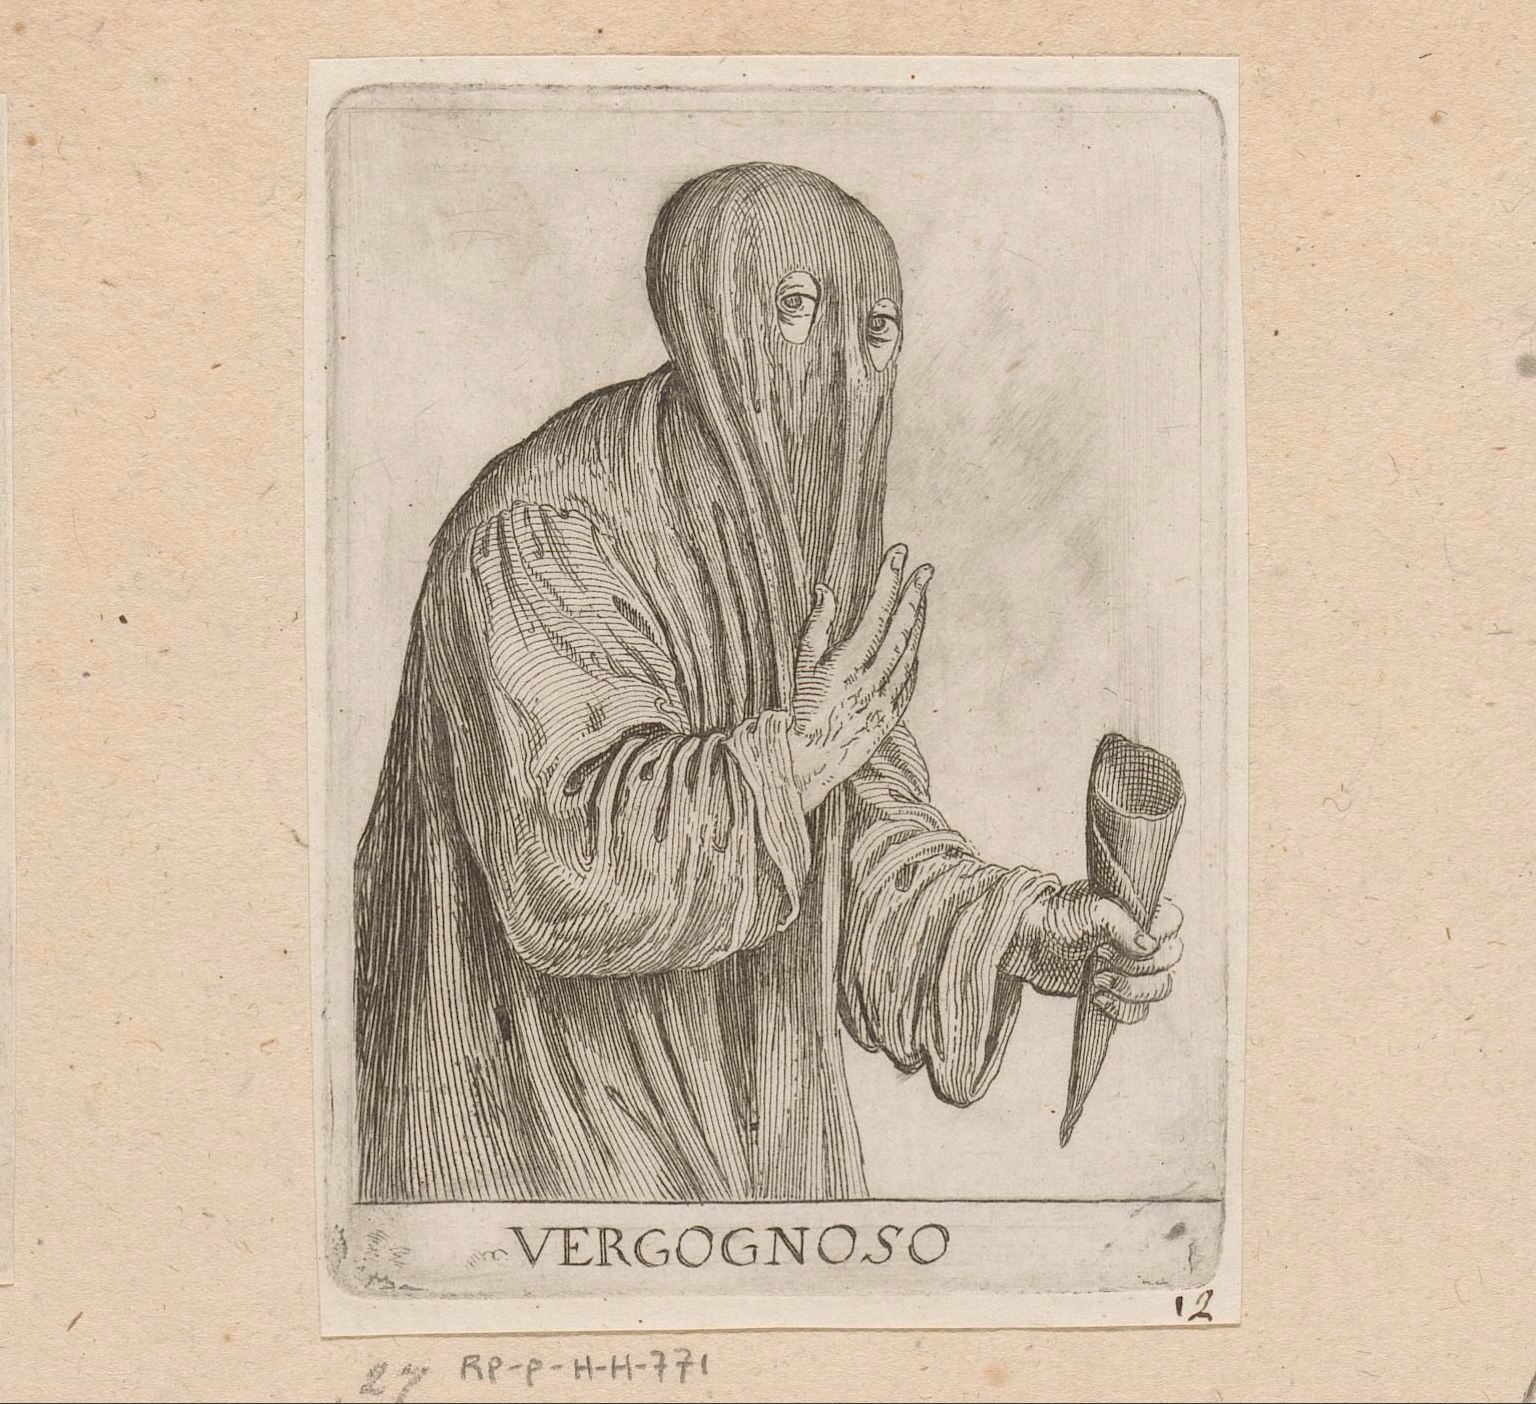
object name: print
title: Beschaamde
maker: francesco villamena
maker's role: draughtsman, painter, print maker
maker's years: 1566-1624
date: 1576-1624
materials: paper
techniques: engraving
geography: italy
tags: folk costume, regional costume, covering the head, drawing drapery over the face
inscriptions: collector's mark: Lugt 10, number: ‘12’, collector's mark: Lugt 11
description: Een staande figuur, over het hoofd een kap dragend waardoor slechts de ogen zichtbaar zijn. Titel in ondermarge.